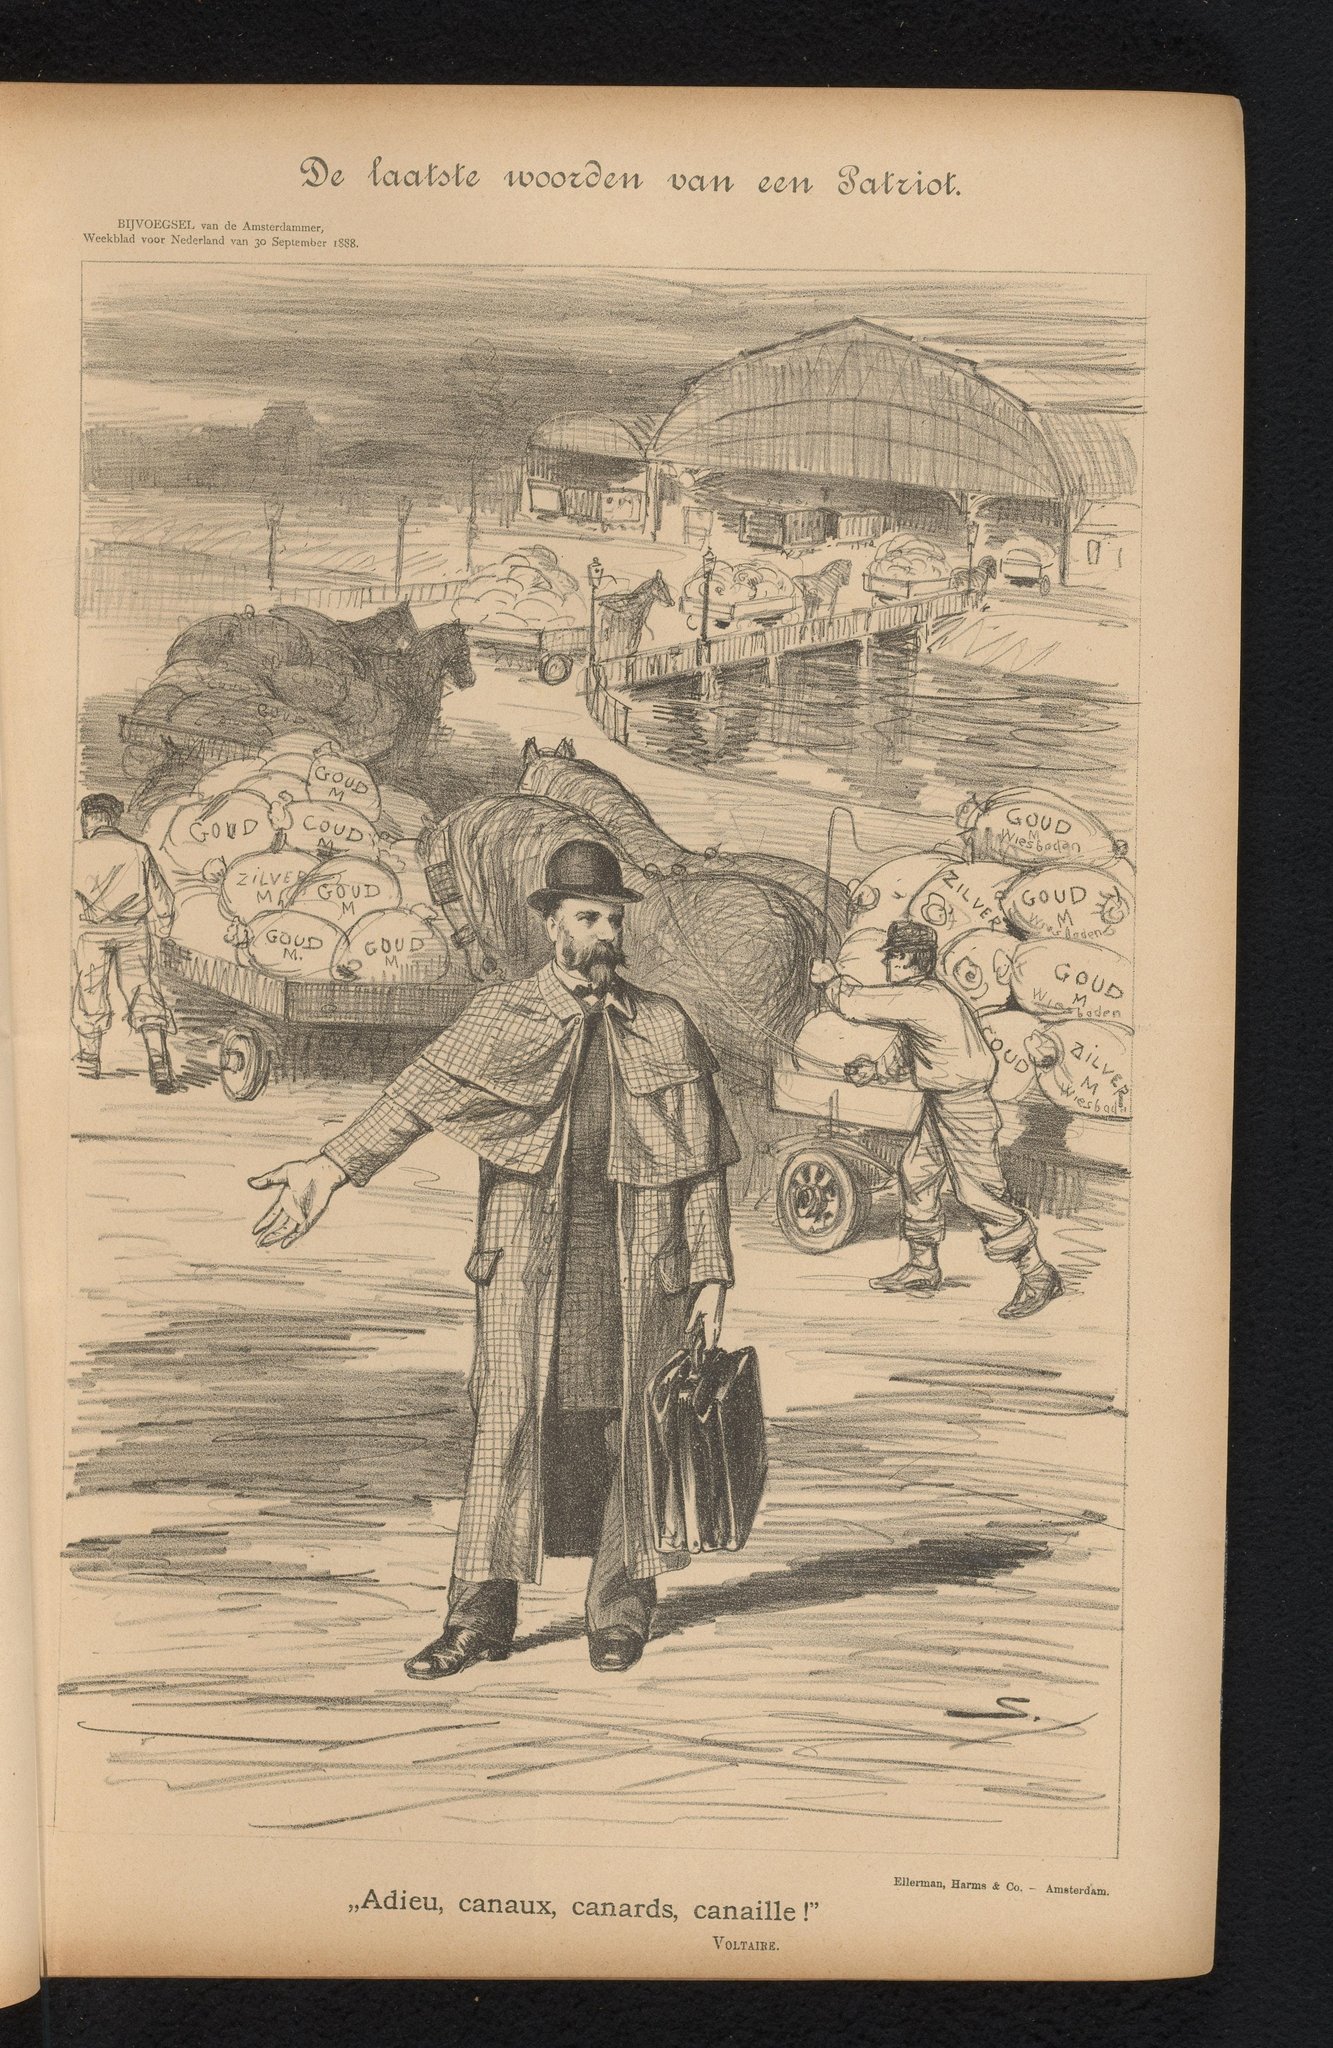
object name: cartoon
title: De laatste woorden van een Patriot. / "Adieu, canaux, canards, canaille!"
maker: willem steelink (ii)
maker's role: draughtsman, print maker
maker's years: 1856-1928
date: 1888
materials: paper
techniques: lithograph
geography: netherlands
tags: amsterdam, physician, doctor, taking leave, political caricatures and satires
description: Dokter Johann Georg Mezger vertrekt in 1888 van Amsterdam naar Wiesbaden. Achter hem worden karren vol goud en zilver, dat hij met zijn dokterspraktijken heeft verdiend, richting het station gebracht.